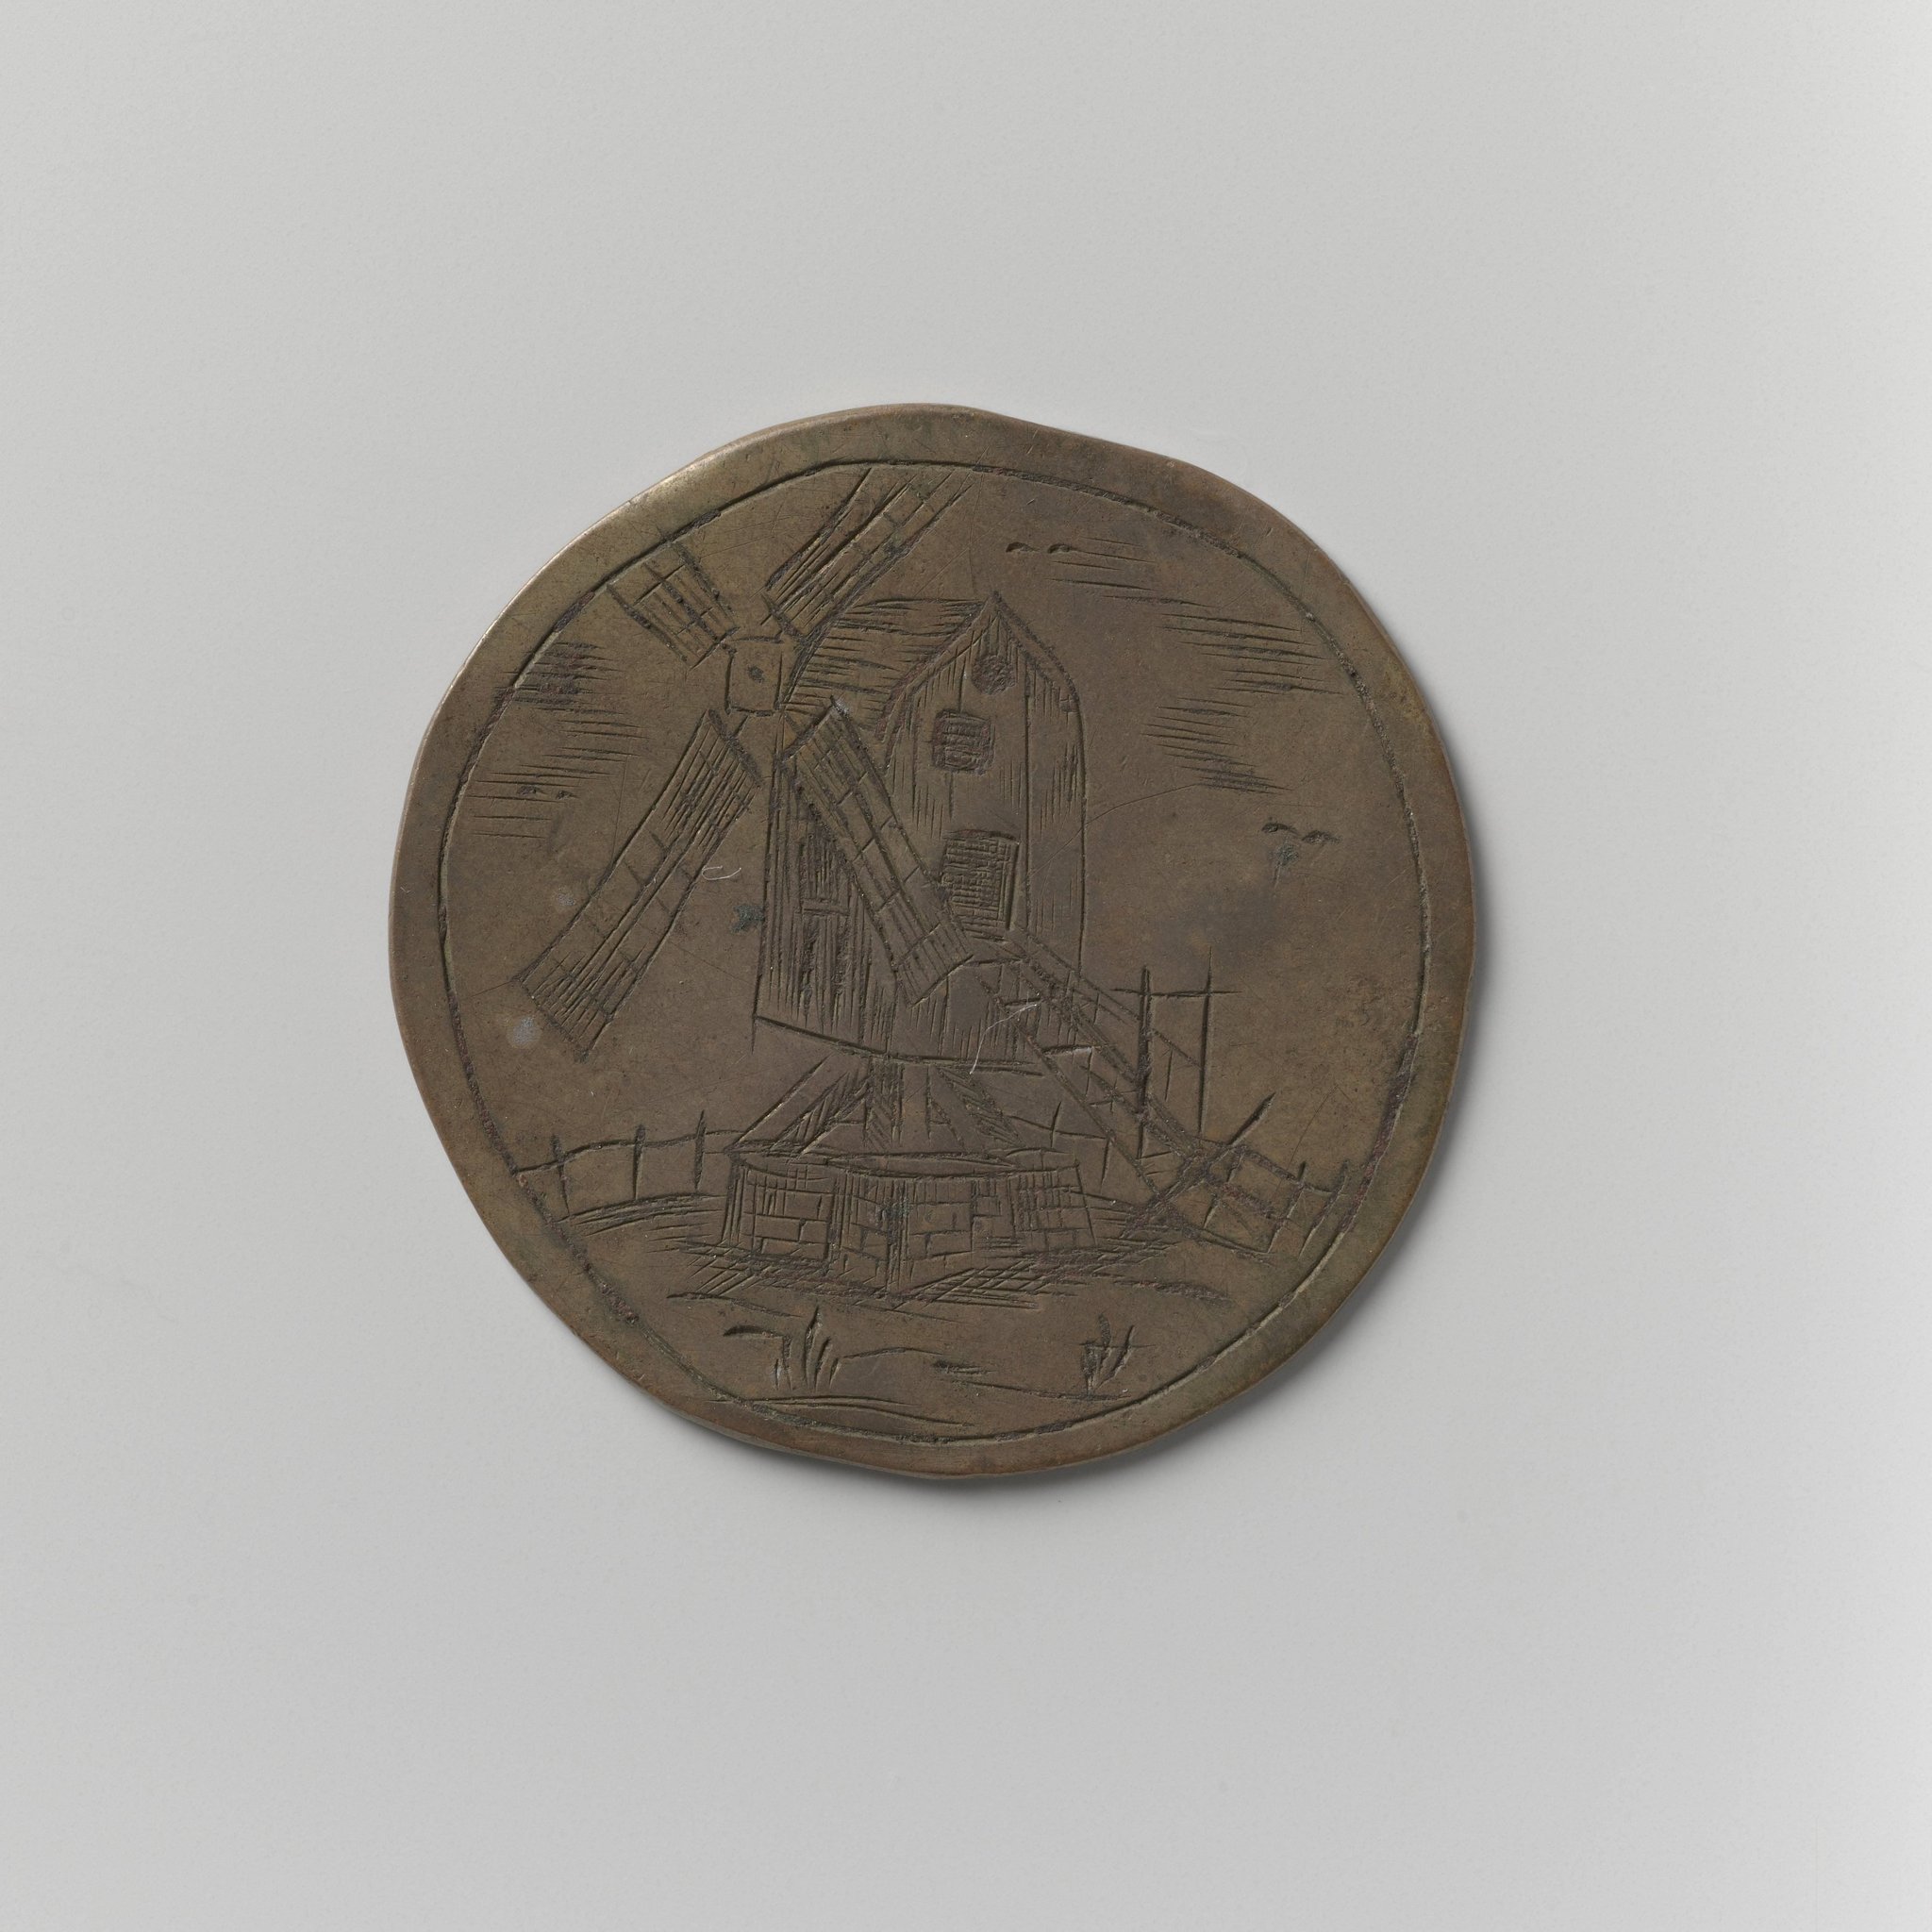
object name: medal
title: Korenmolenaarsgilde van Amsterdam, gildepenning van A.F. van Wijk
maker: Anonymous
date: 1832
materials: copper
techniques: engraving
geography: amsterdam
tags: amsterdam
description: Koperen penning. Voorzijde: korenmolen. Keerzijde: opschrift